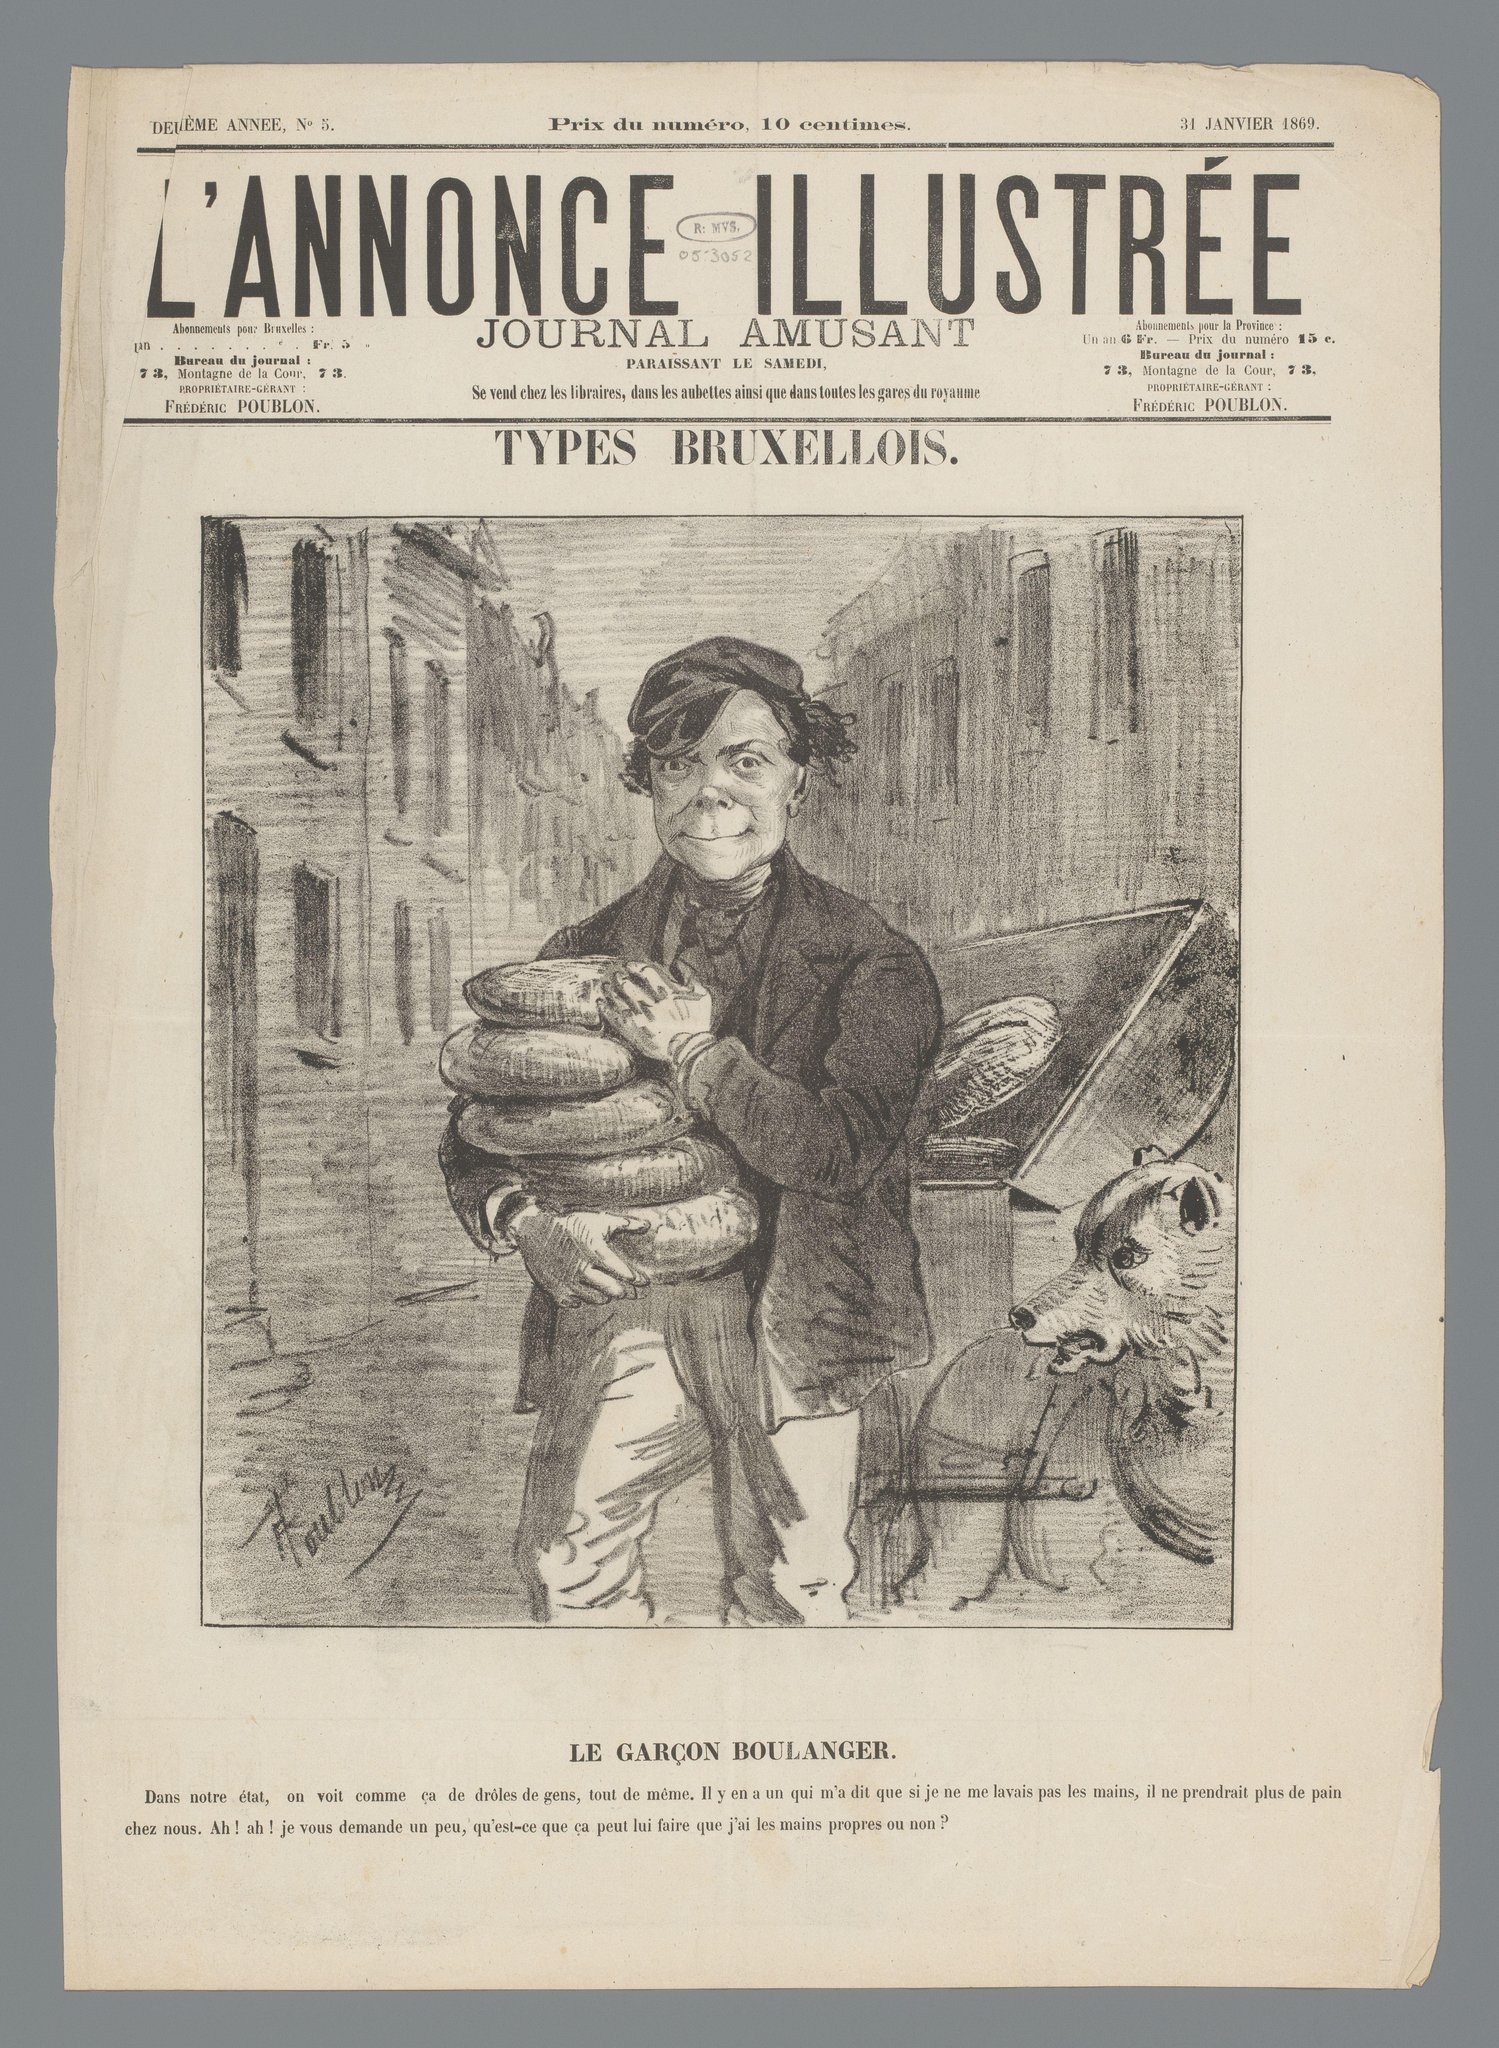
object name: print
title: Le garçon boulanger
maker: frédéric poublon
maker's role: print maker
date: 1869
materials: paper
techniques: letterpress printing, lithograph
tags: street-trader, baker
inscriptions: collector's mark: Lugt 2228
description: Prent op voorpagina van: L'Annonce Illustrée, Journal Amusant, 31 januari 1869. Op verso de helft van een lithografie, voorstellend een begrafenisstoet, met eronder de titel "Enterrement".